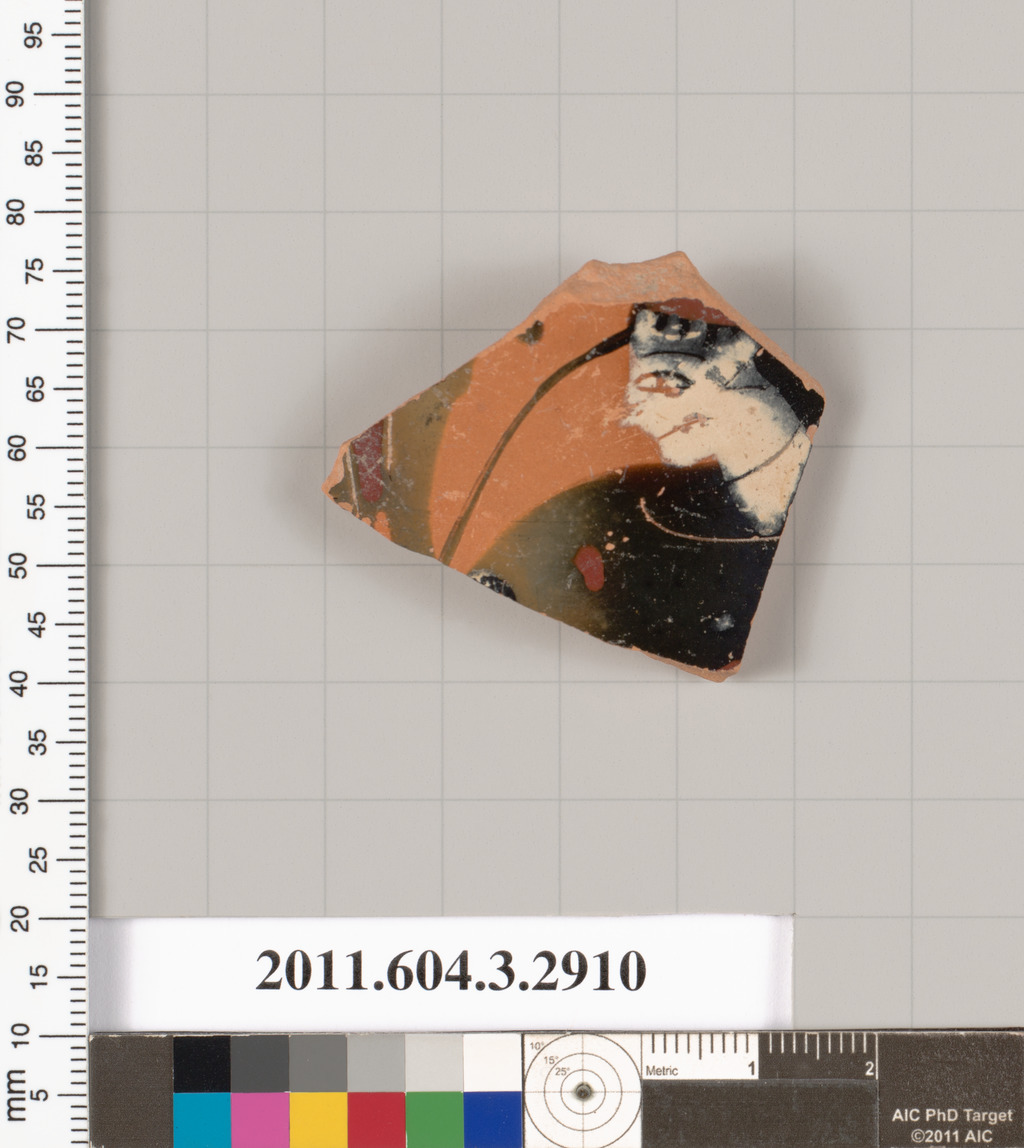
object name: lekythos fragment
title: Terracotta fragment of a lekythos (oil flask)?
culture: greek, attic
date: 534-501 BCE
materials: terracotta